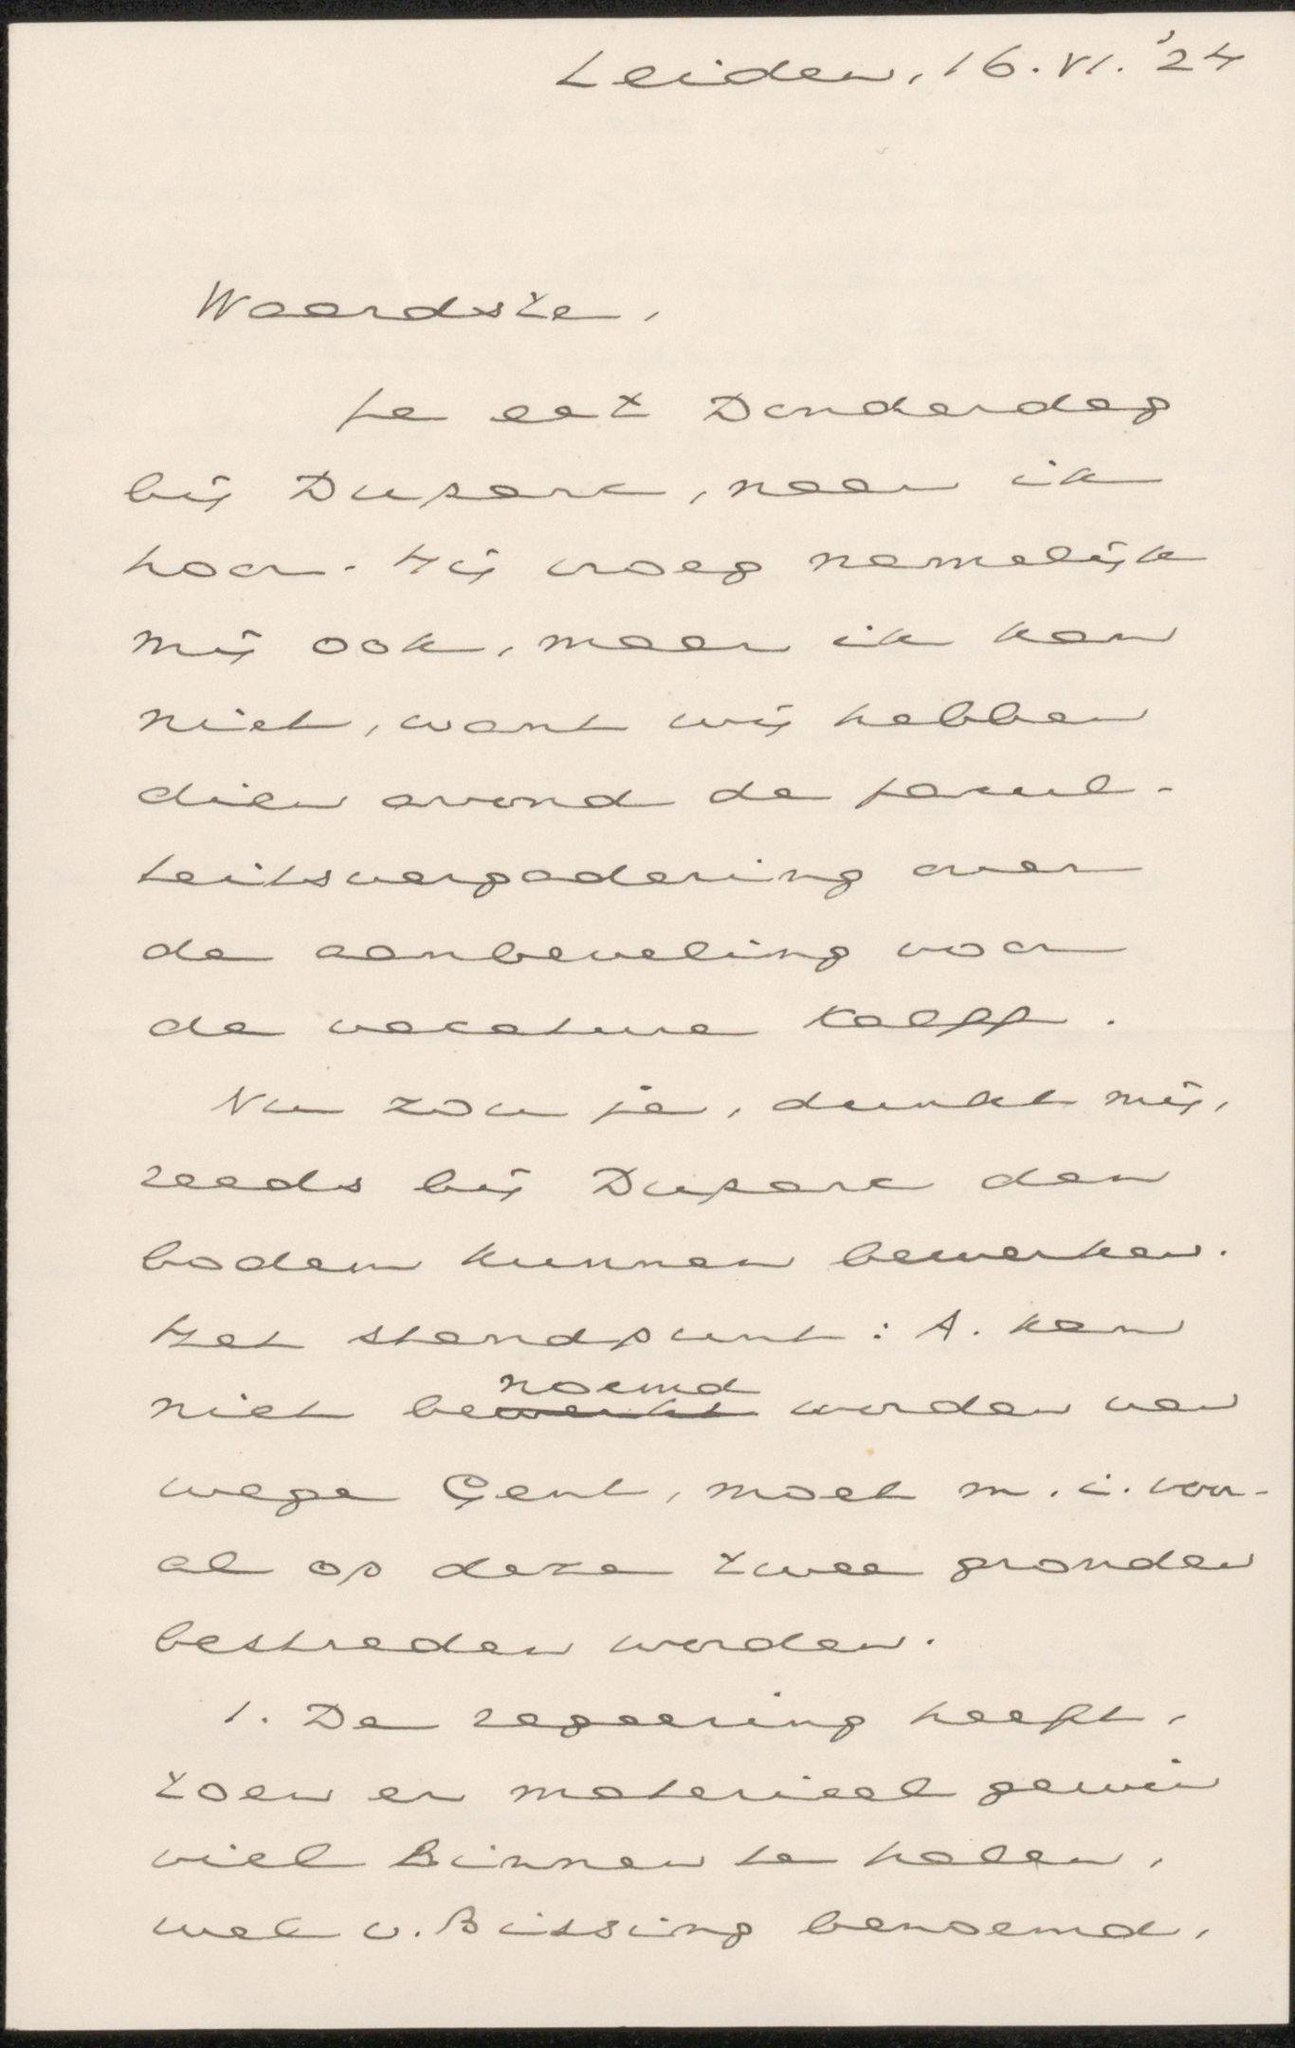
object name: letter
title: Brief aan Jan Veth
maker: johan huizinga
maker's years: 1872-1945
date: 1924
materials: ink, paper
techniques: pen, writing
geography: leiden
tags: dordrecht, painter, print maker, draughtsman, designer, jan veth, jan kalf, andré jolles, mozes isaac duparc, the hague, ghent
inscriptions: watermark, collector's mark: ‘RPK’